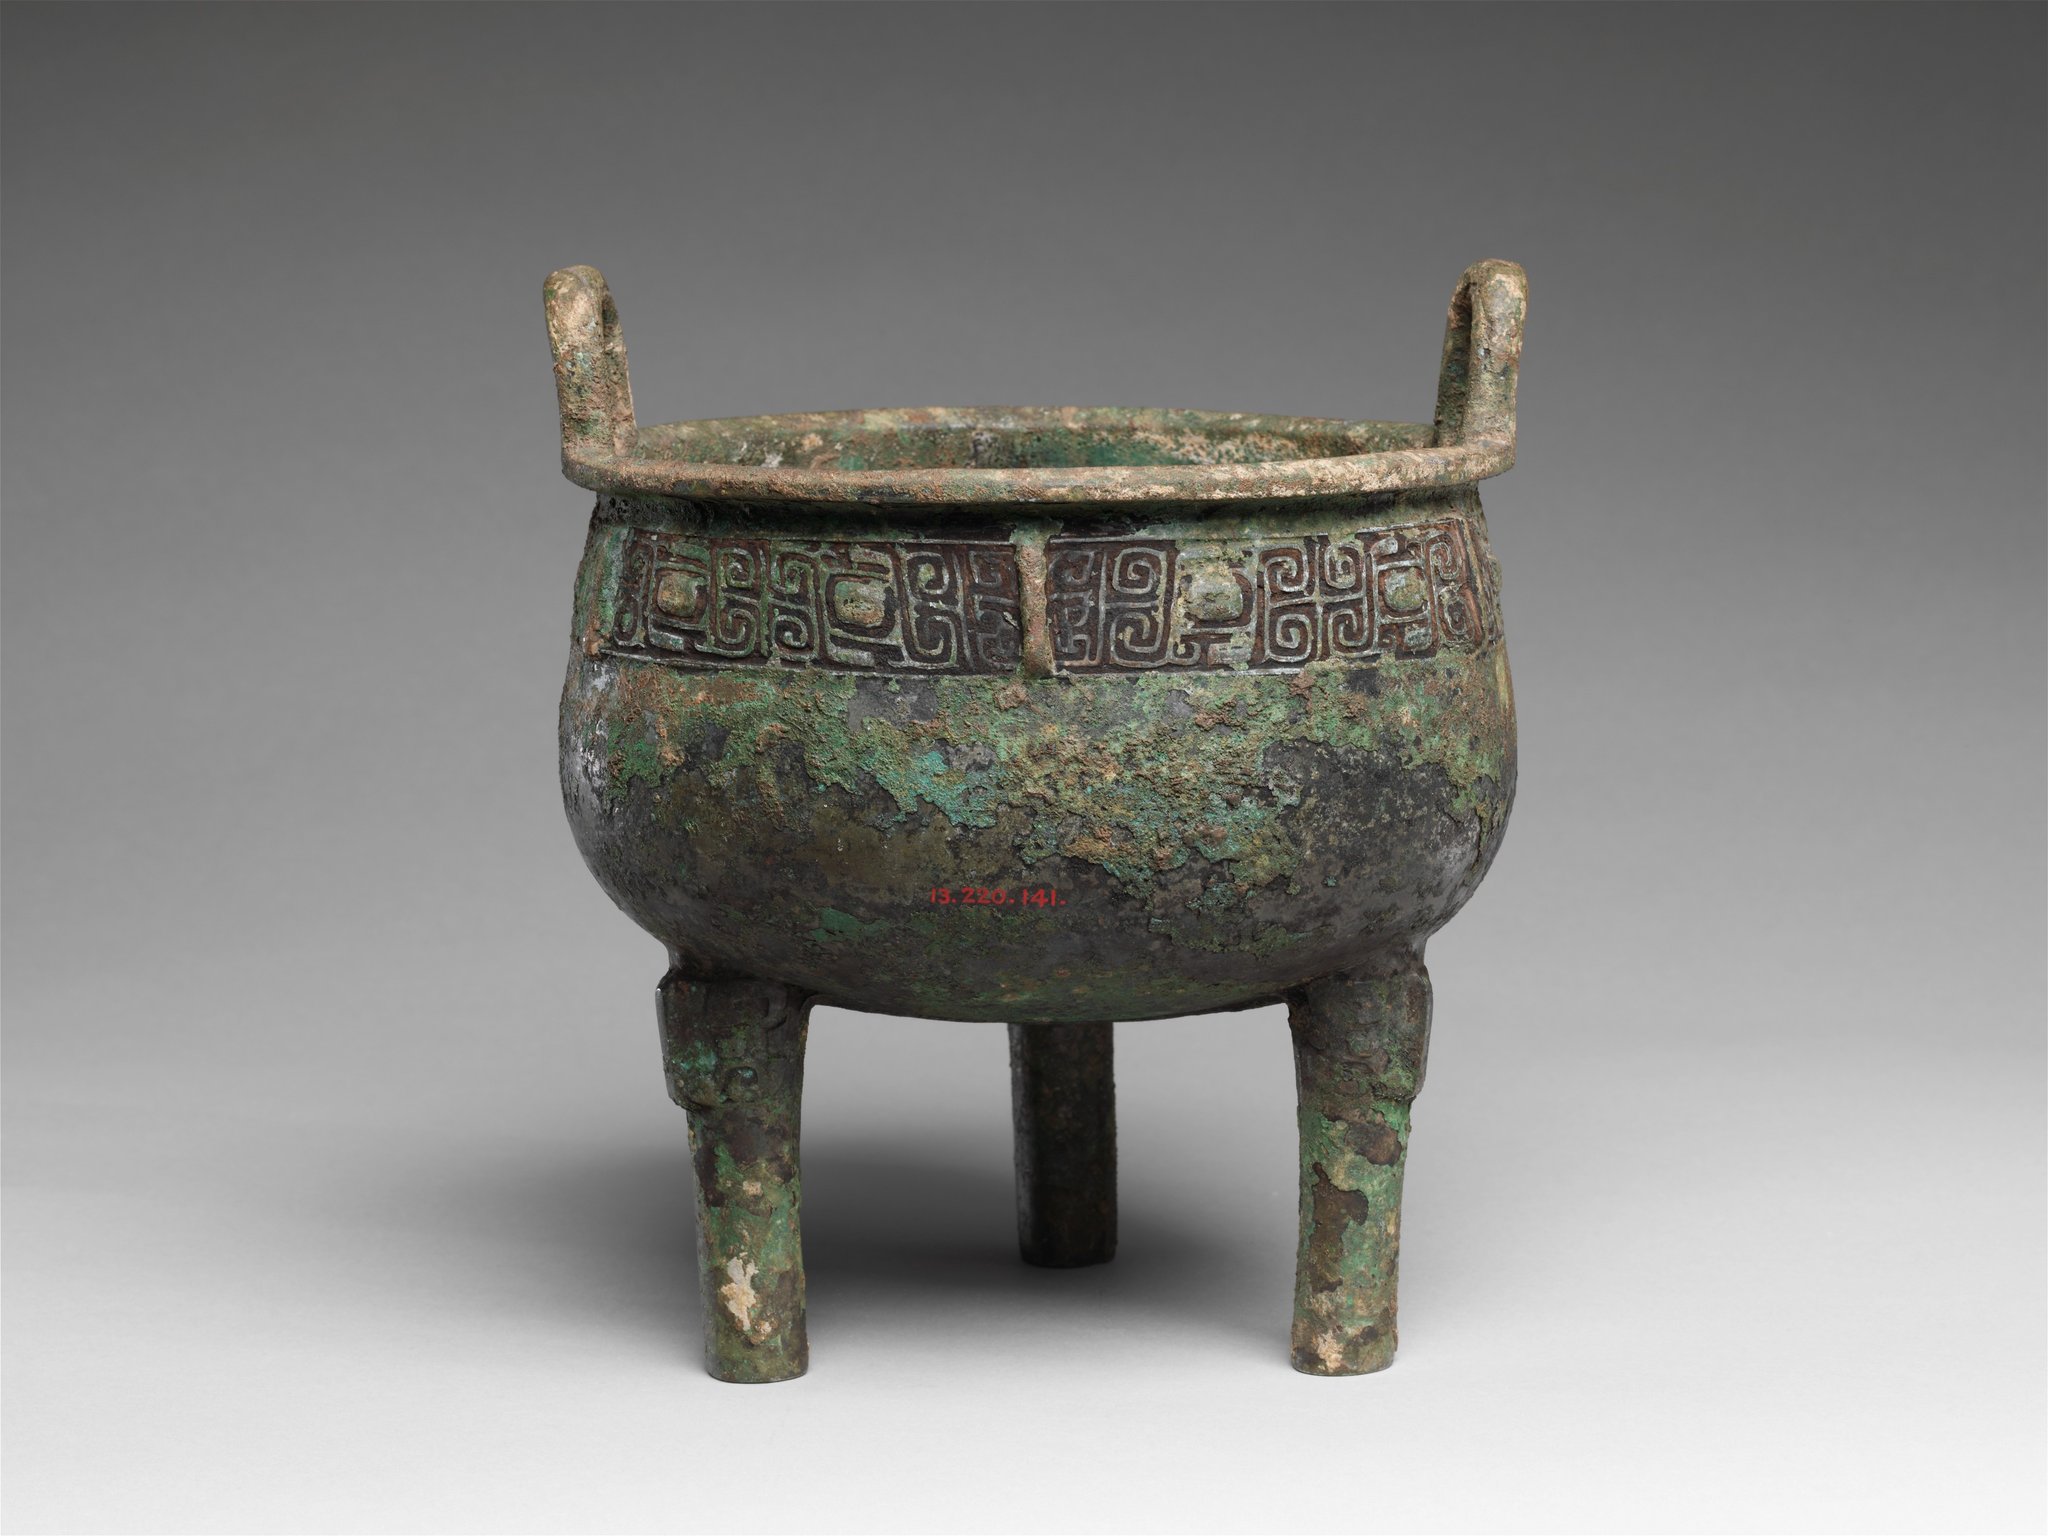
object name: cauldron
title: Tripod cauldron (Ding)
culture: chinese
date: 1300-1201 BCE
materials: bronze